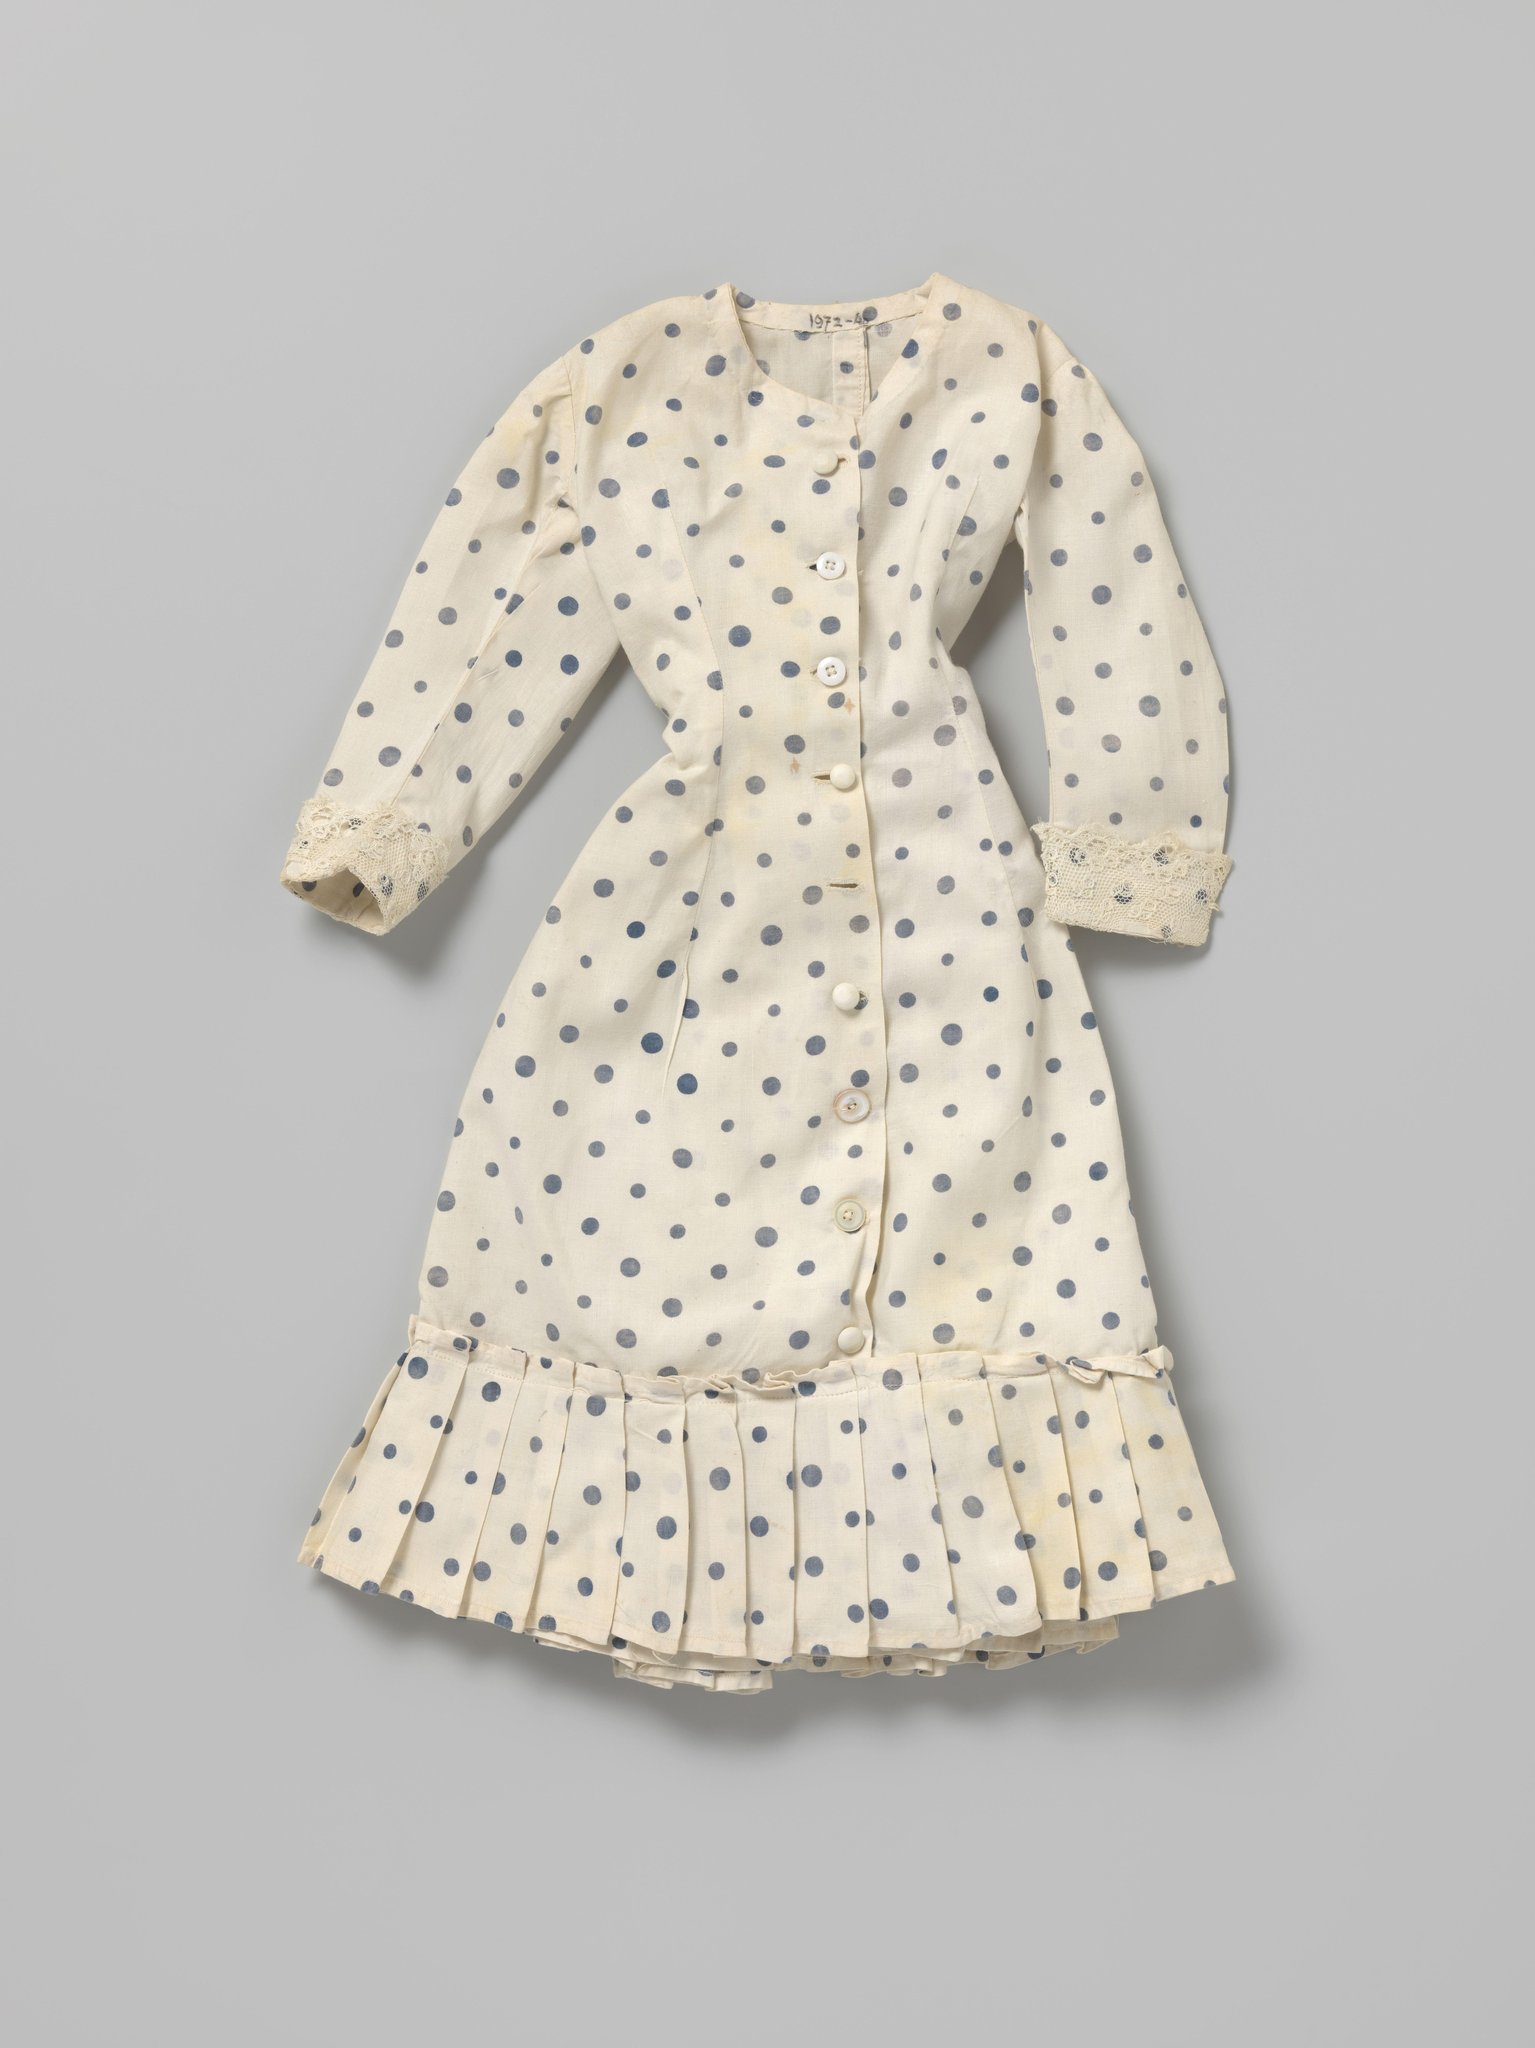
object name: doll's clothing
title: Jurk van witte katoen met blauwe noppen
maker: Anonymous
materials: cotton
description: Jurk van witte katoen met blauwe noppen.